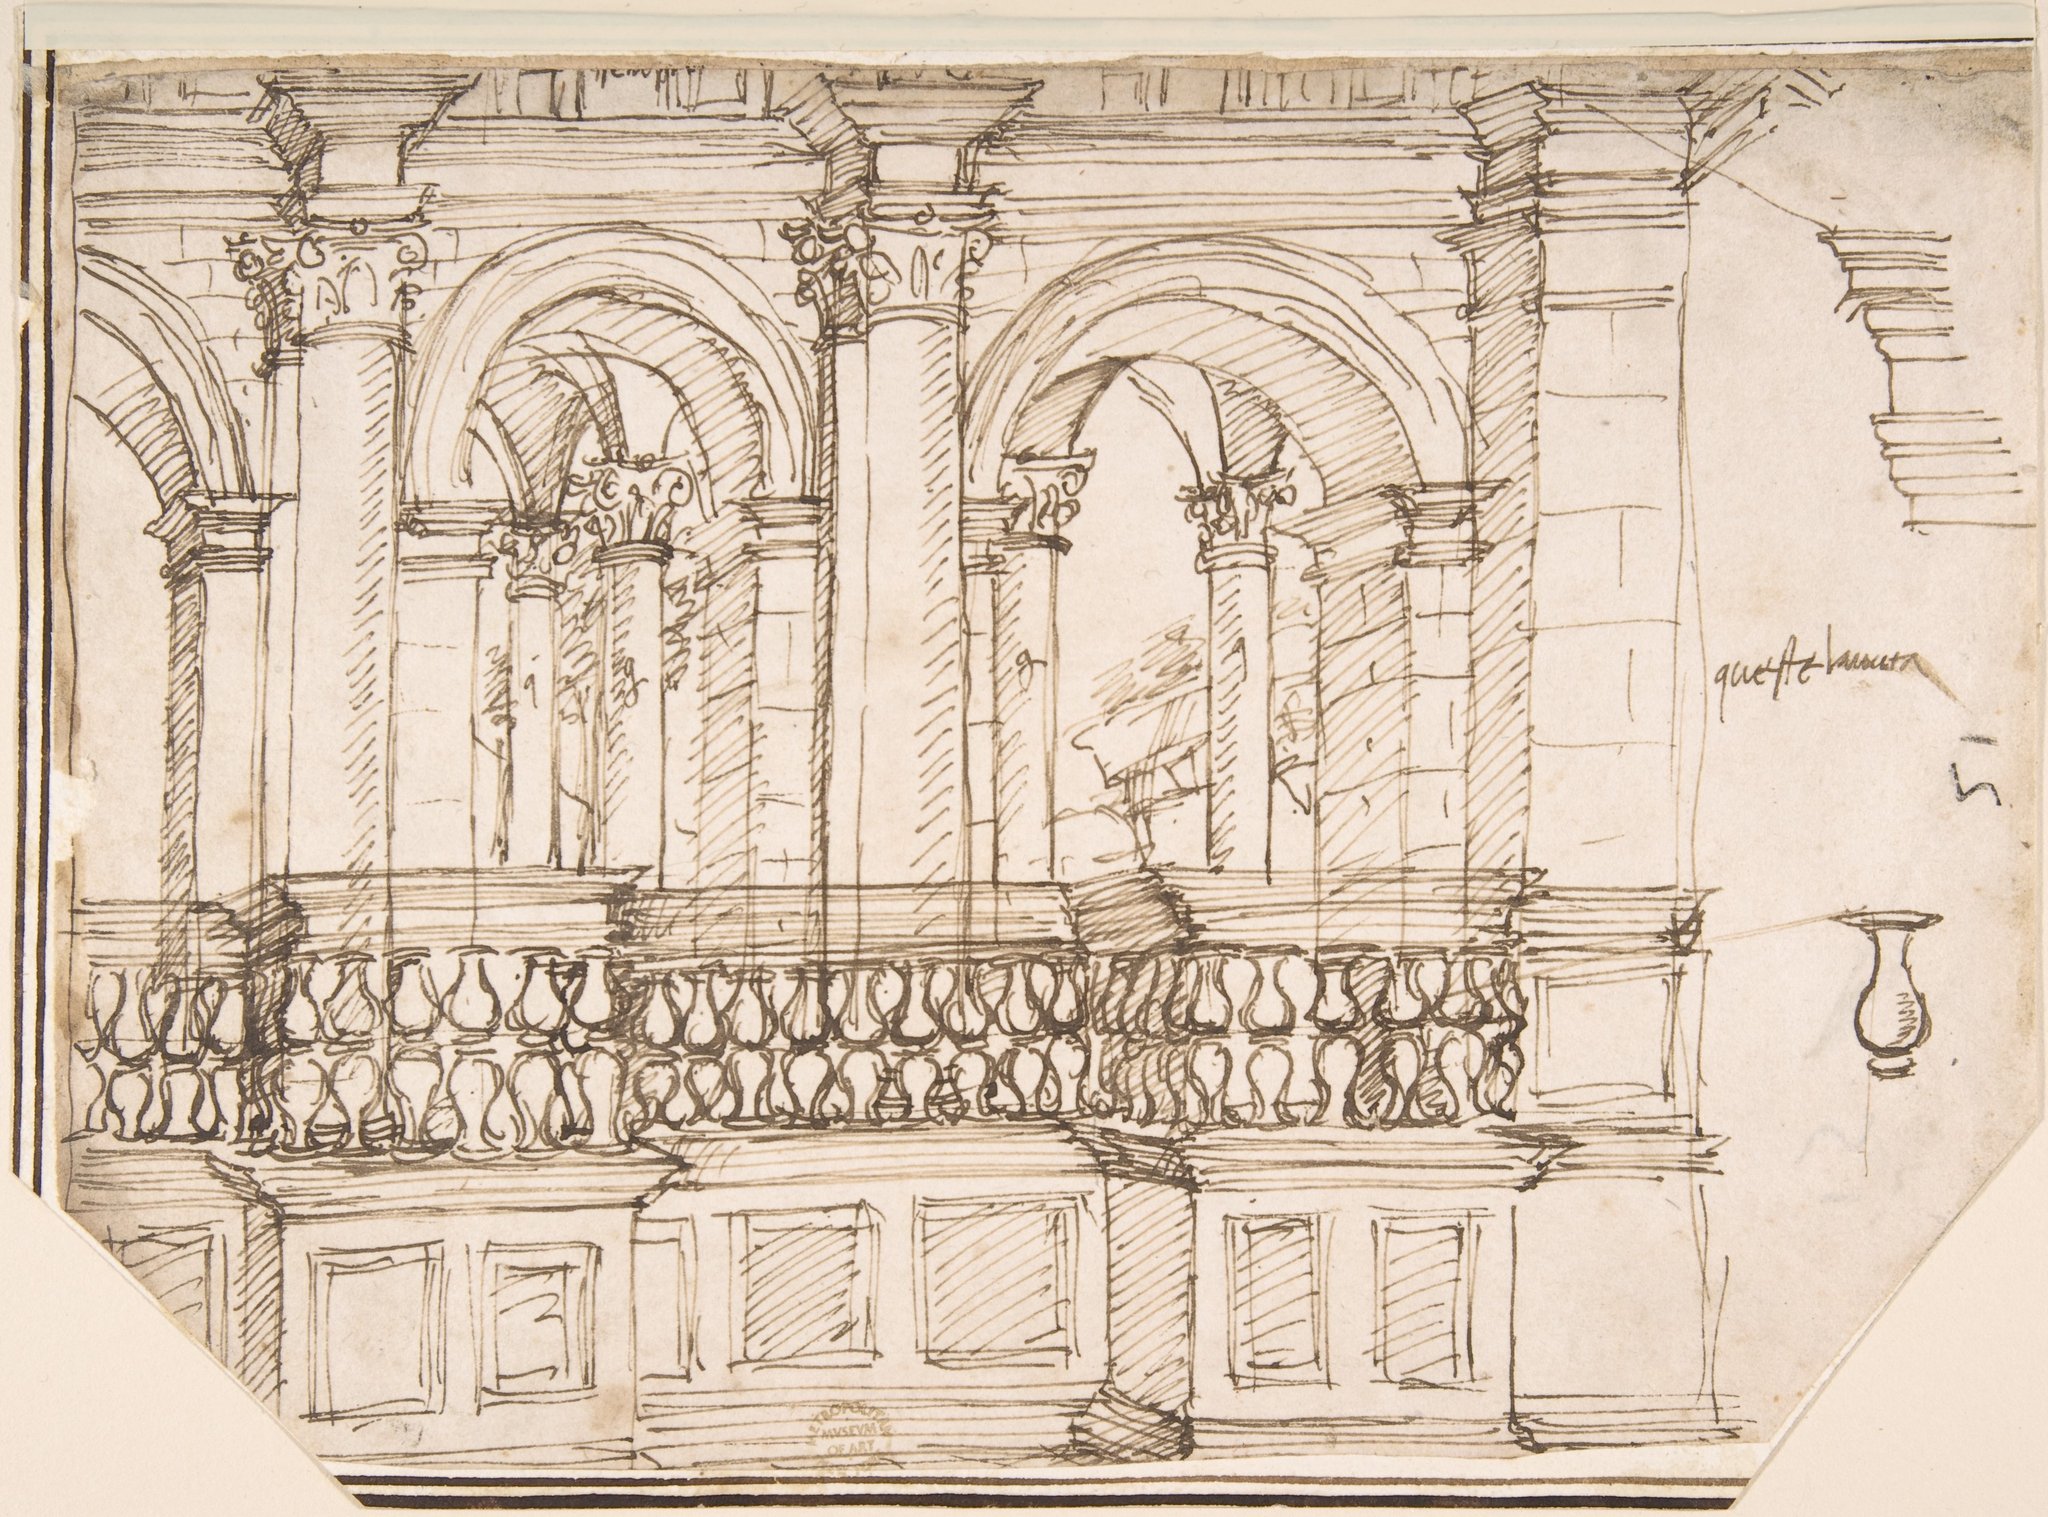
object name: drawing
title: Arcade in the Balustrade (Stage Setting?)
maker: anonymous, italian, 16th century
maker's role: artist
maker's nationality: italian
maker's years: 1550-1600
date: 1501-1600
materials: ink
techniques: pen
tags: arches,columns